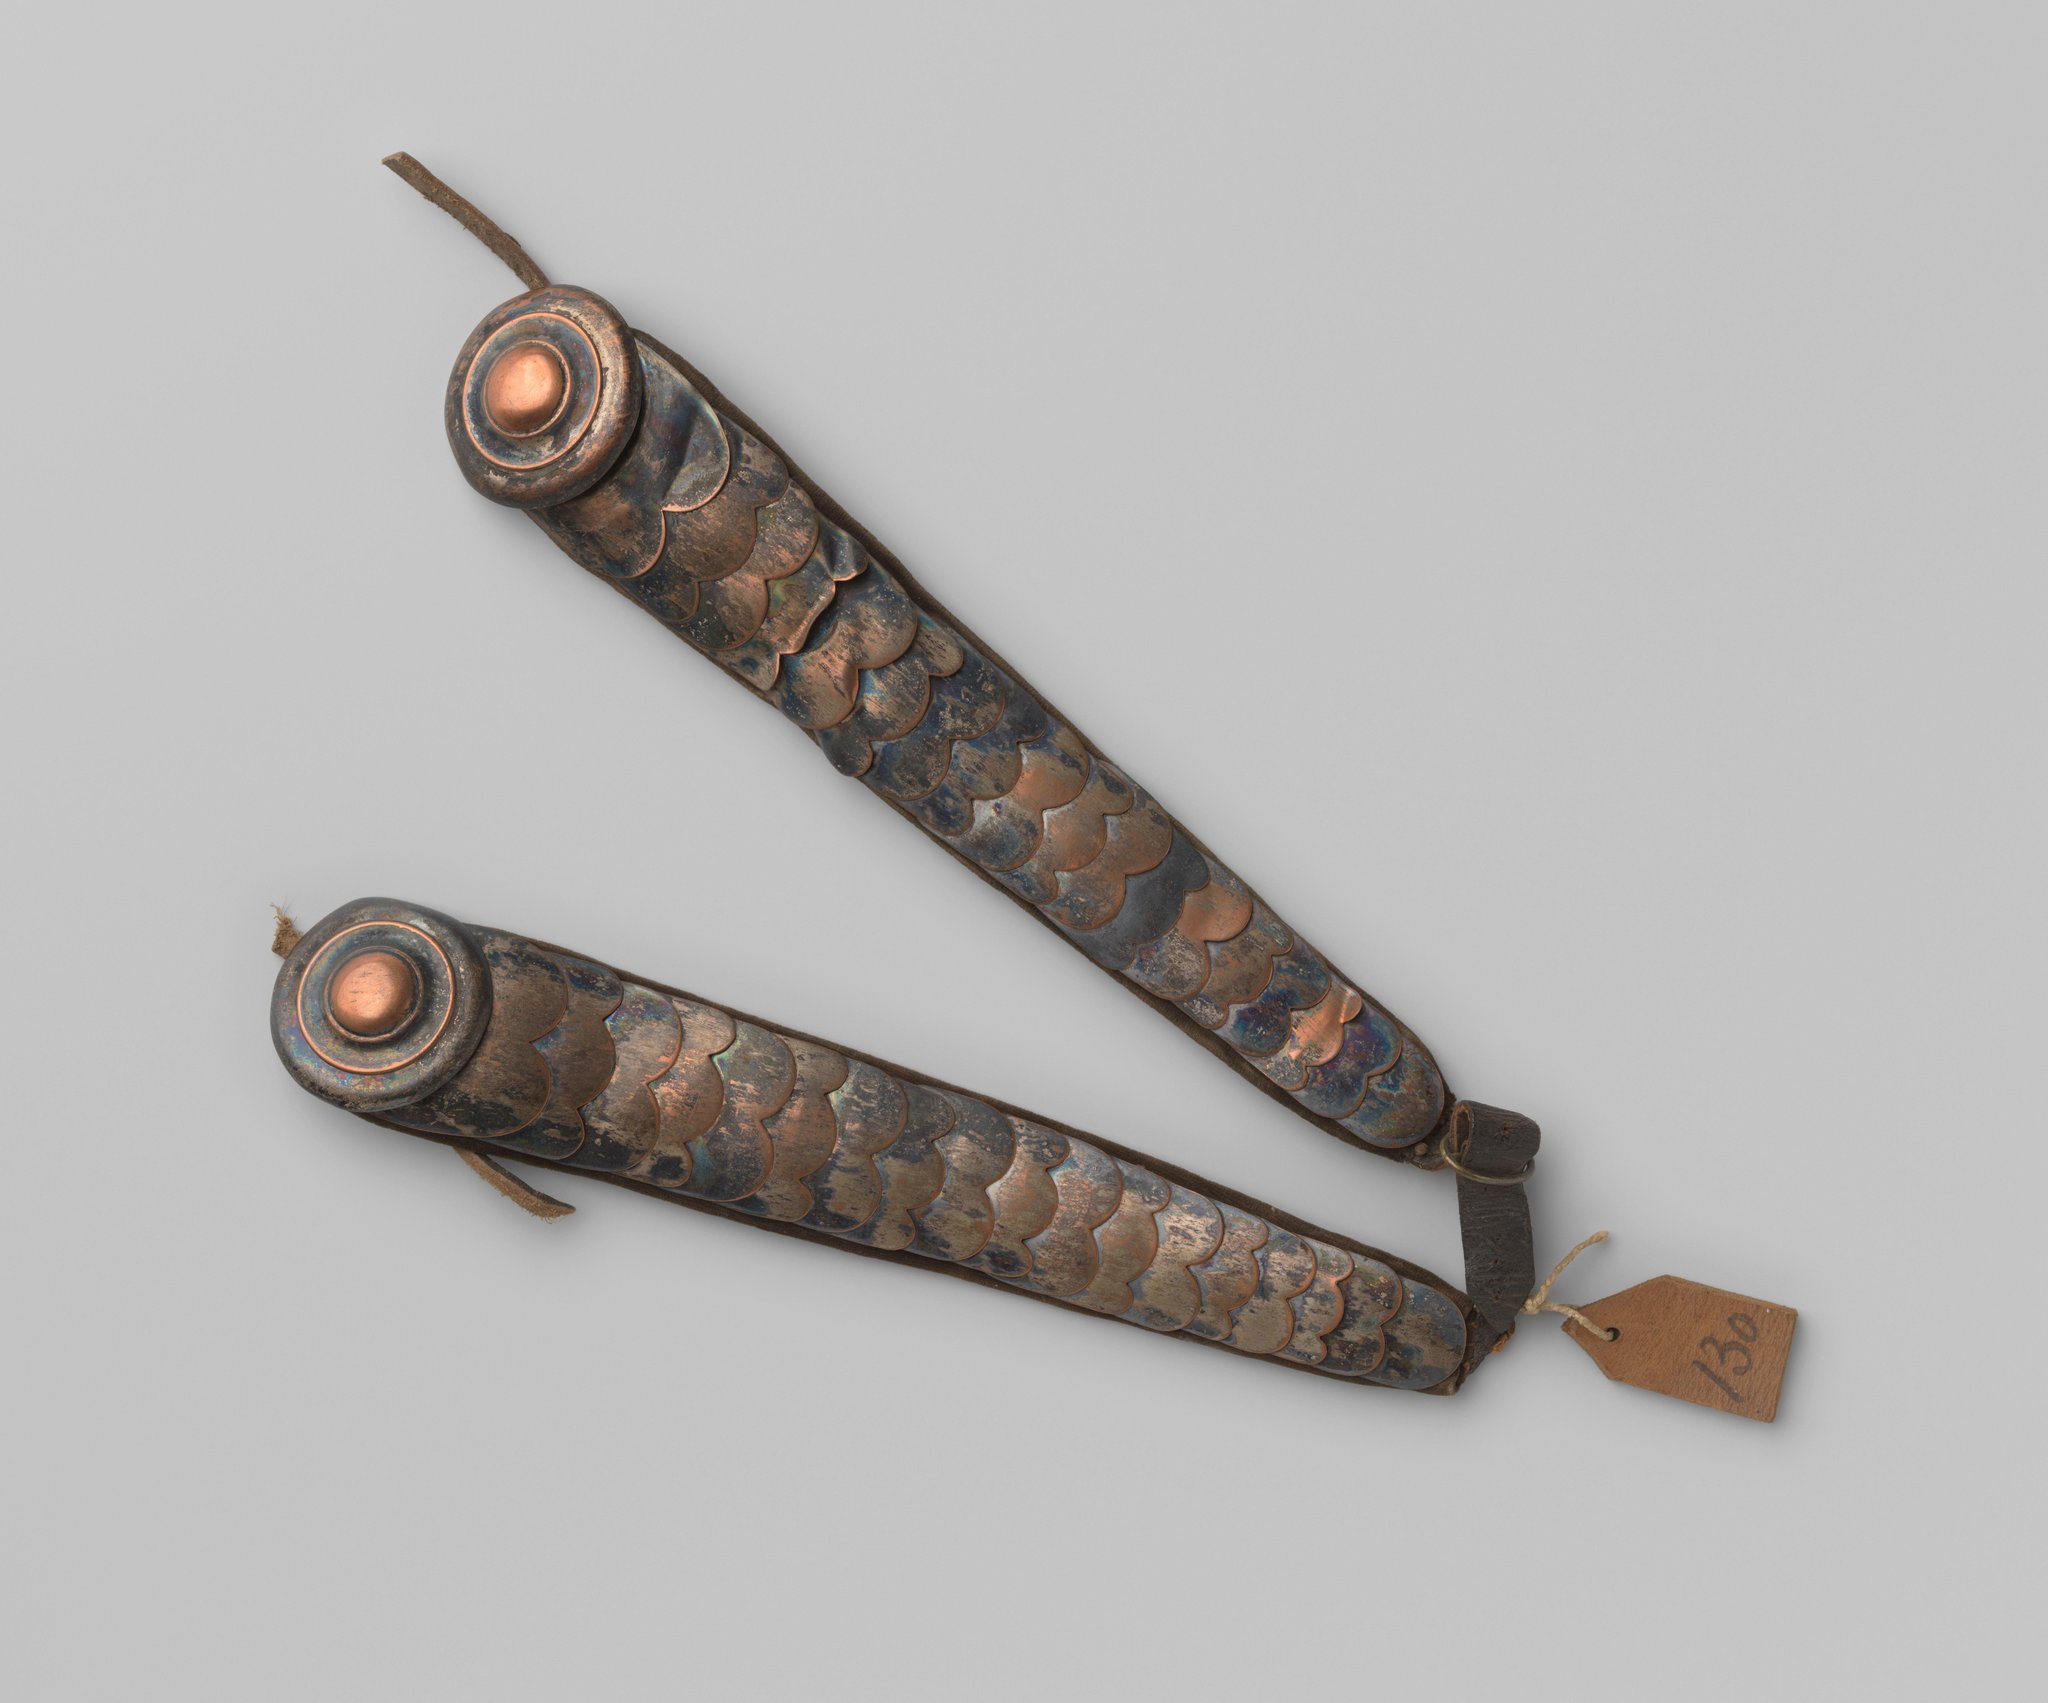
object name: shako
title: Kinband met rozetten voor sjako officier schutterij, ca. 1830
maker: Anonymous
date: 1830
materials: iron, leather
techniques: pressing, silvering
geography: netherlands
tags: koninklijke landmacht, noord-hollandse schutterij, brummen, koopman, frederick bogaardt, noord-holland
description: Kinband, van achttien geschubde plaatjes, gegolfd, van verzilverd rood metaal. Bovenkant voorzien van rond metalen rozet, achterzijde hiervan met ring waardoor leren veter. Bevestigd op bruine stof. Kinbanden aan elkaar verbonden met gesp. Afkomstig van F. Boogaard, kapitein 2e bataljon 3e afdeling mobiele Noord-Hollandse schutterij.